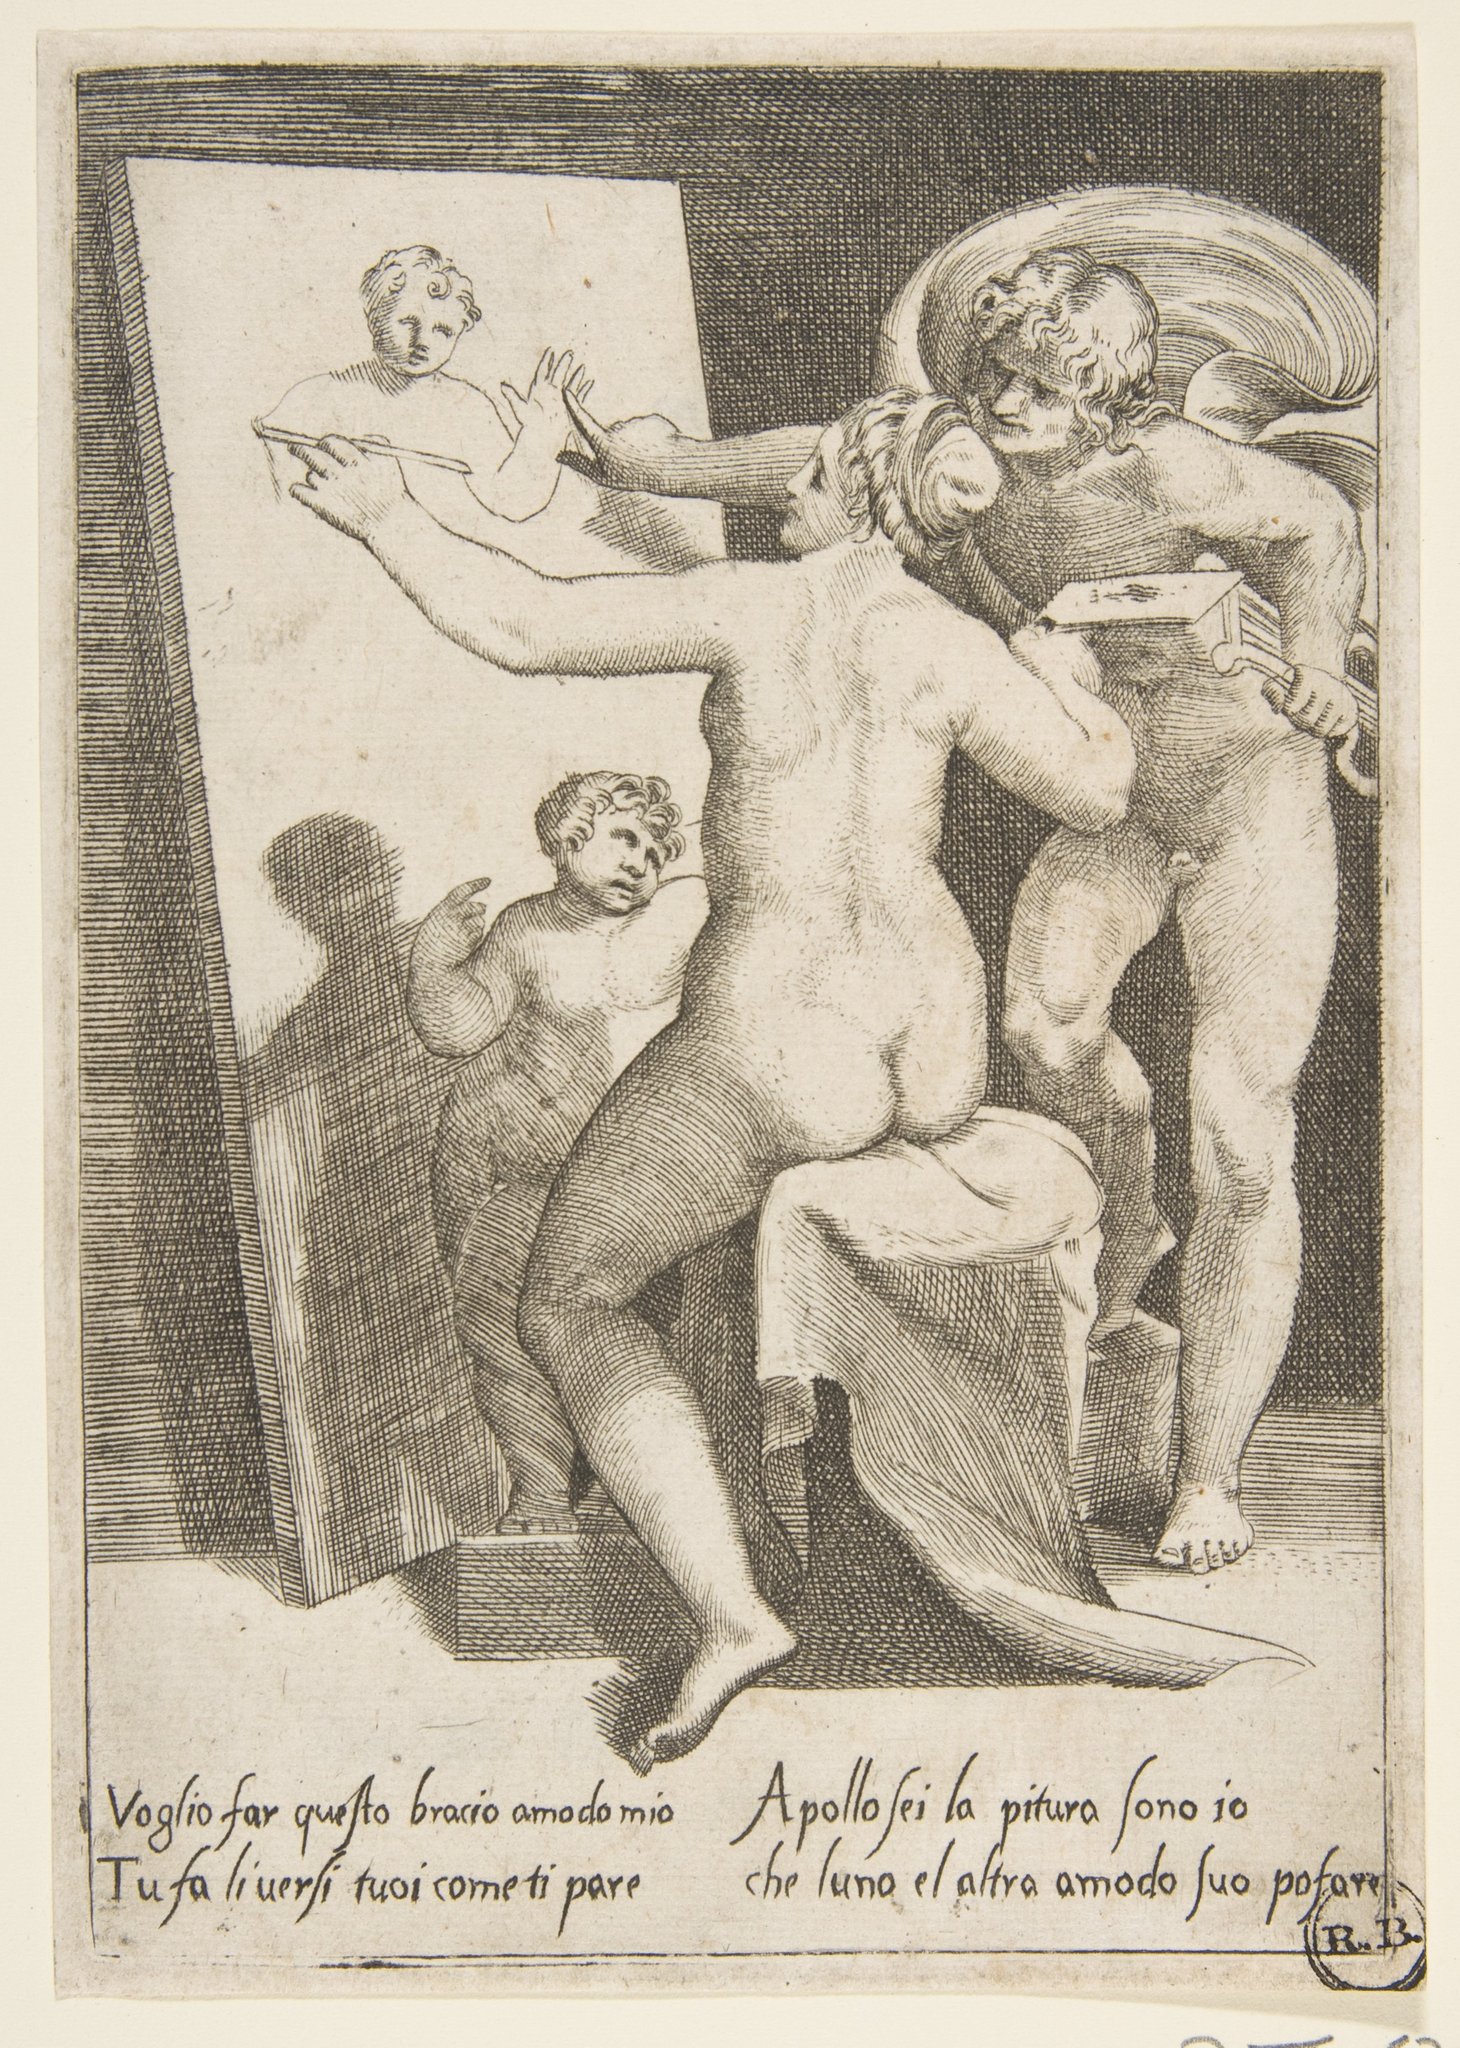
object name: print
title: Apollo standing a beside a woman representing an allegory of painting, from "The Loves of the Gods"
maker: giulio bonasone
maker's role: artist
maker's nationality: italian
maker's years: 1510-1576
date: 1531-1560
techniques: engraving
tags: painting,female nudes,apollo